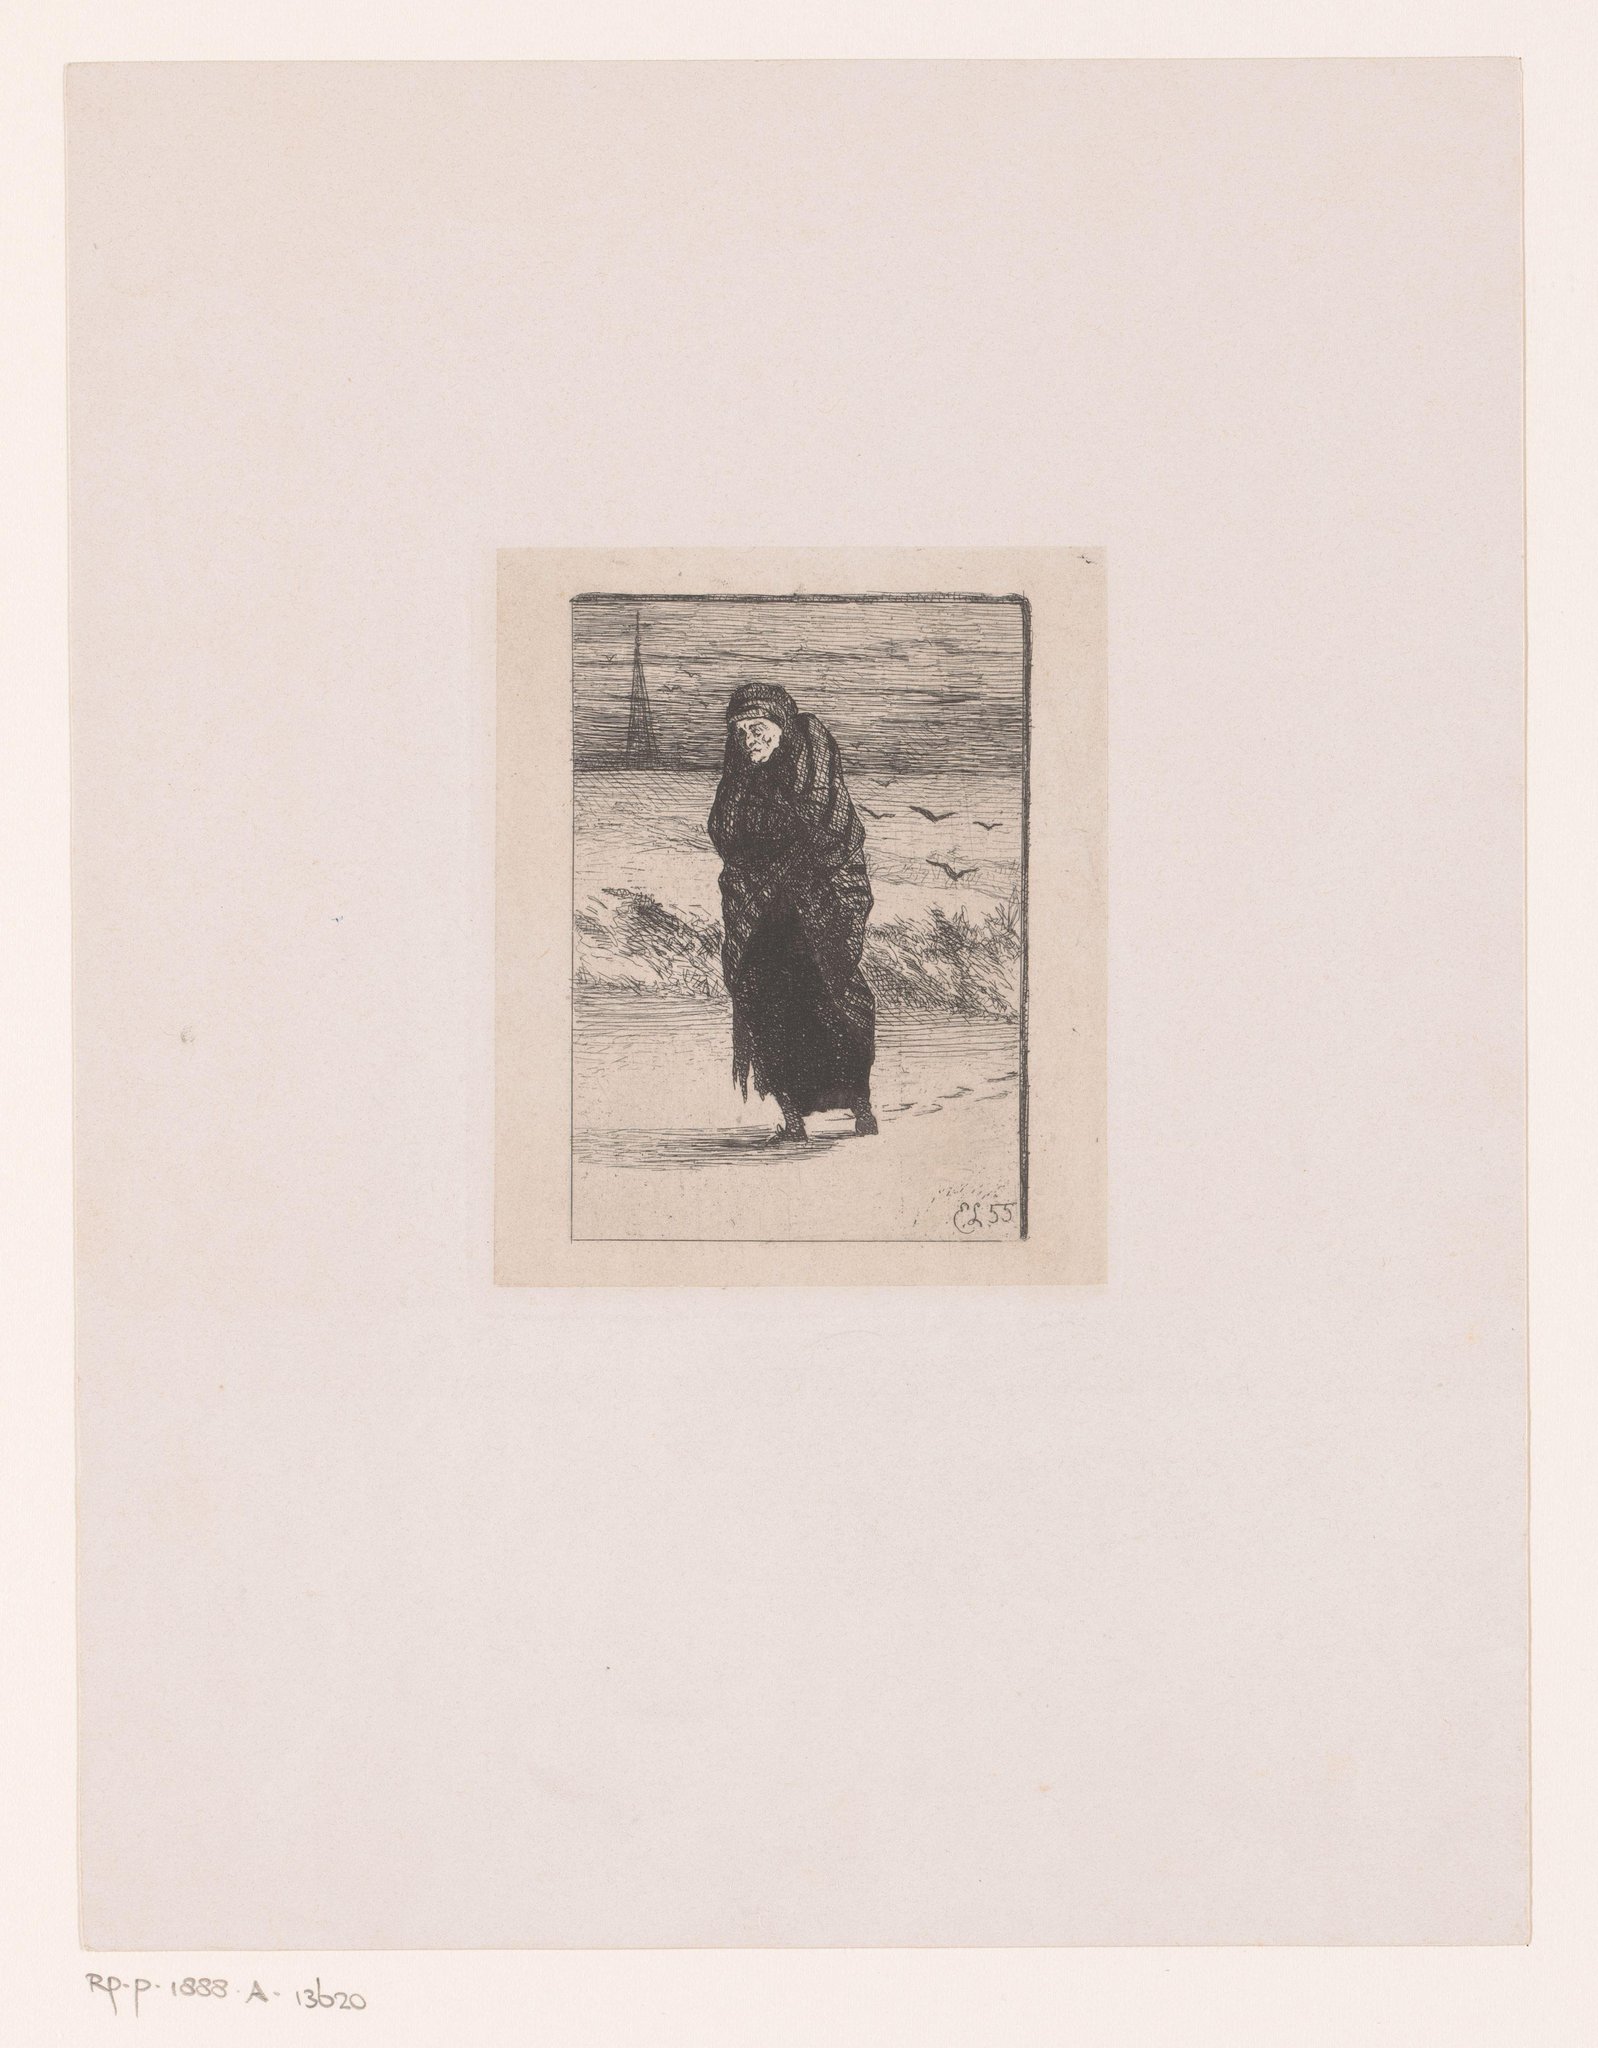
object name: print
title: Oude vrouw loopt in de sneeuw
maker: edmond lambrichs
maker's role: print maker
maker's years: 1830-1887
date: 1855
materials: paper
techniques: etching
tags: old woman, snow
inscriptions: collector's mark: Lugt 2228